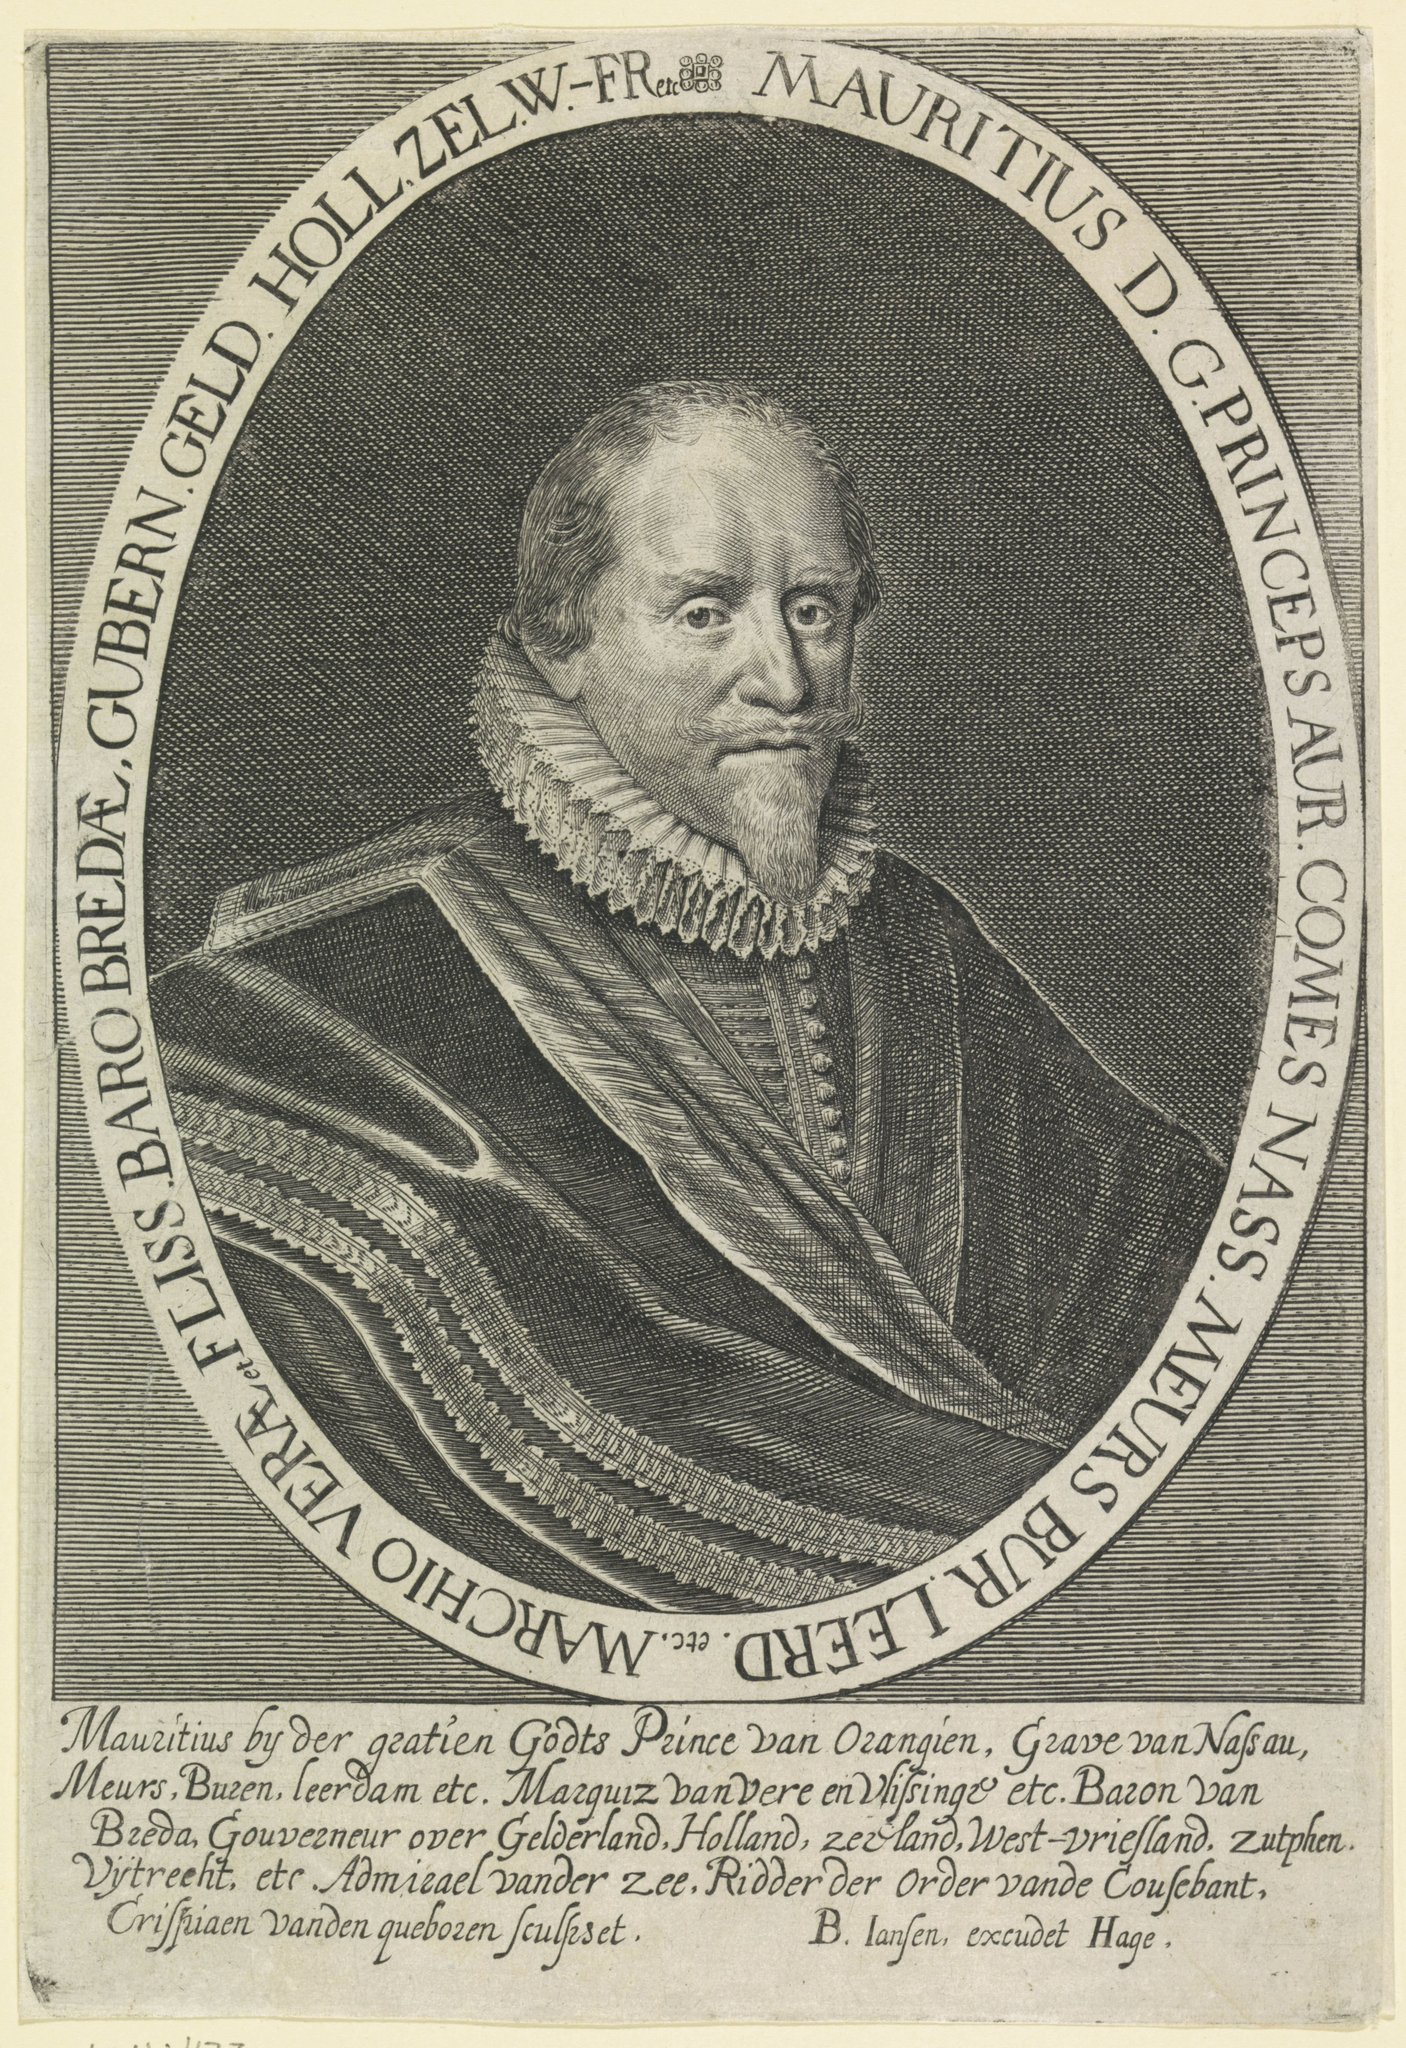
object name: print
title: Portret van Maurits, prins van Oranje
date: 1586-1626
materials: paper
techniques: engraving, etching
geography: antwerp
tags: the hague, maurice (prince of orange)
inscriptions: collector's mark: Lugt 2228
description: De hier vermelde titel verwijst naar de hoogst verkregen titel van de geportretteerde, niet per se naar de titel die de geportretteerde op deze voorstelling draagt.